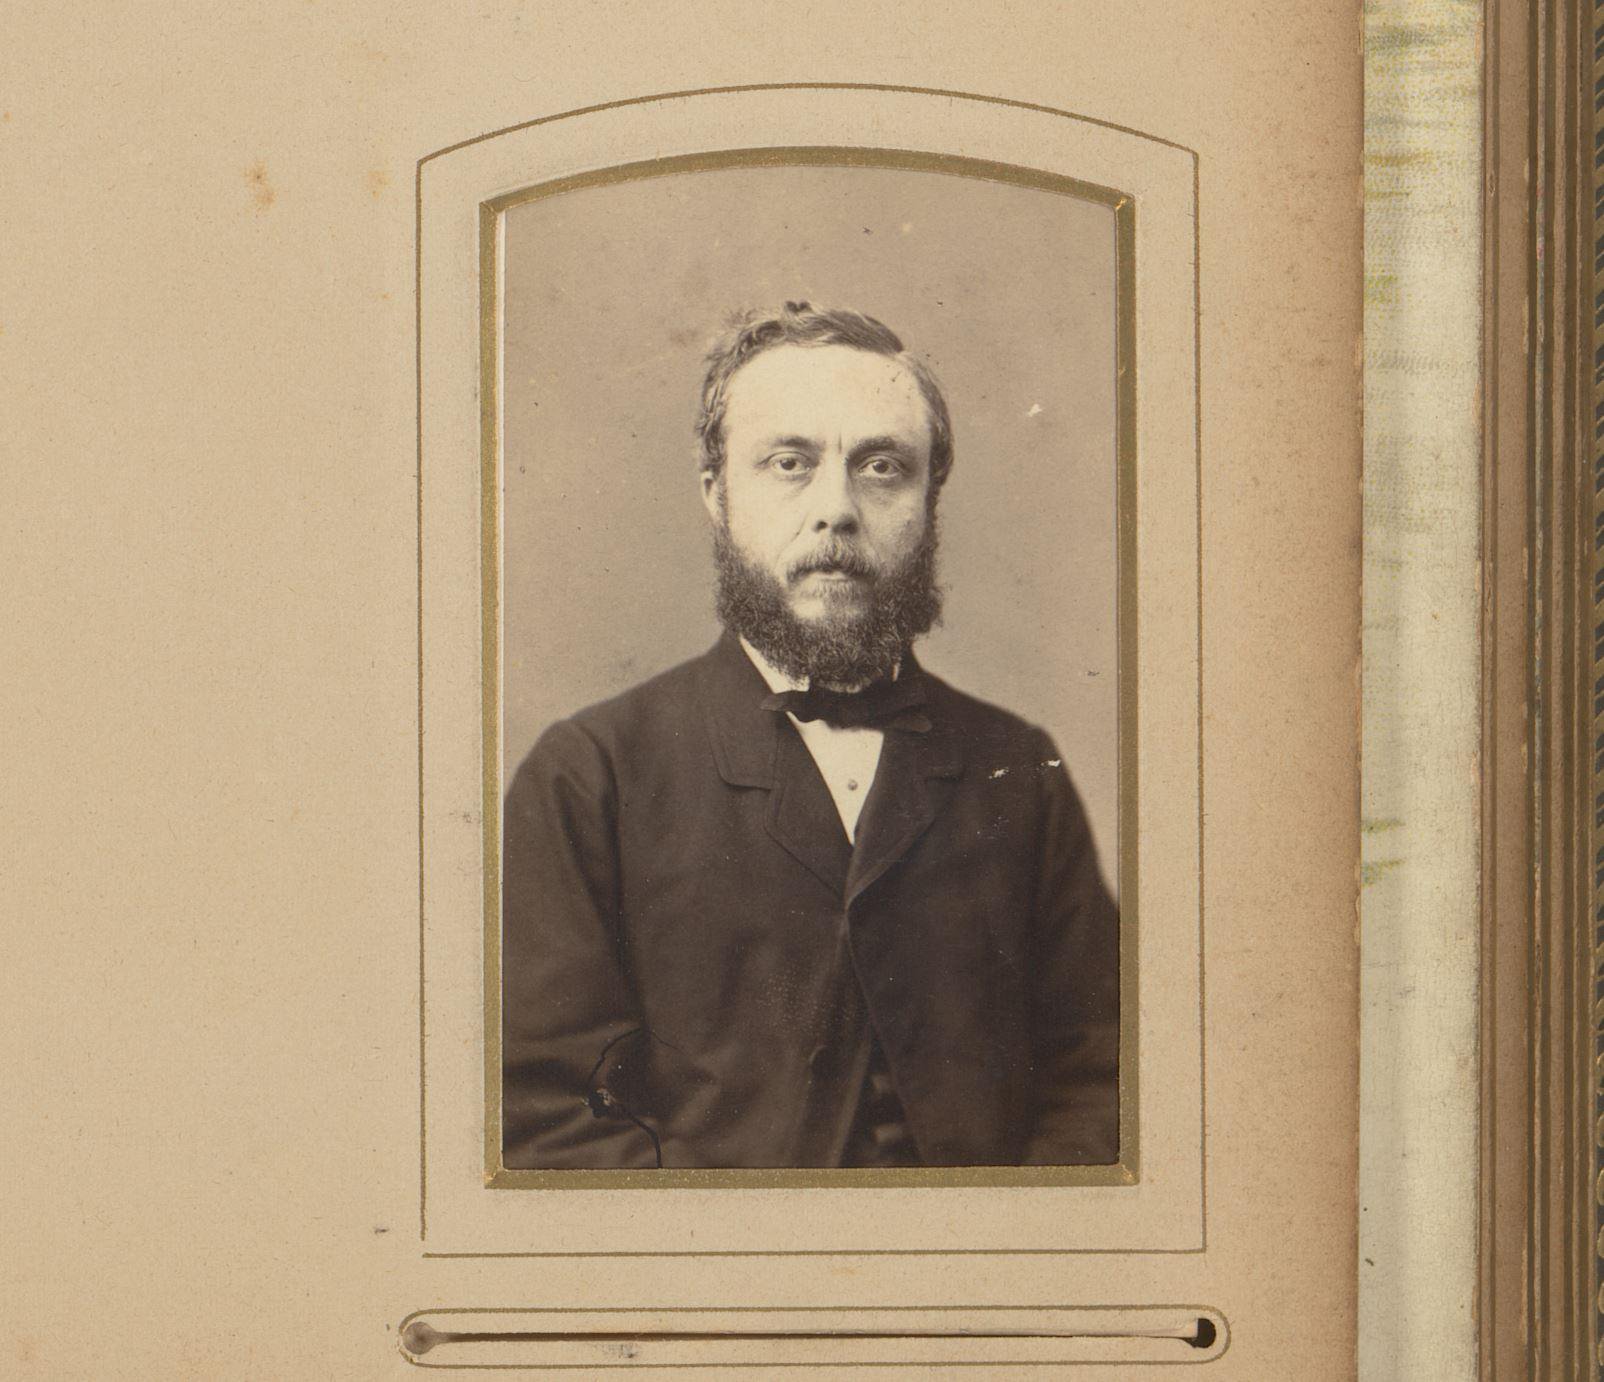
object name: album leaf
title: Portret van een man met snor en baard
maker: j. servais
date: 1860-1900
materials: cardboard, photographic support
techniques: albumen print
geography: liège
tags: moustache, historical persons, beard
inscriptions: name: ‘[...]le[.]ers’, inscription: ‘(...0/ J. SERVAIS/ PHOTOGRAPHE/ 5, Rue de l'Agneau, 5/ À/ LIÈGE’